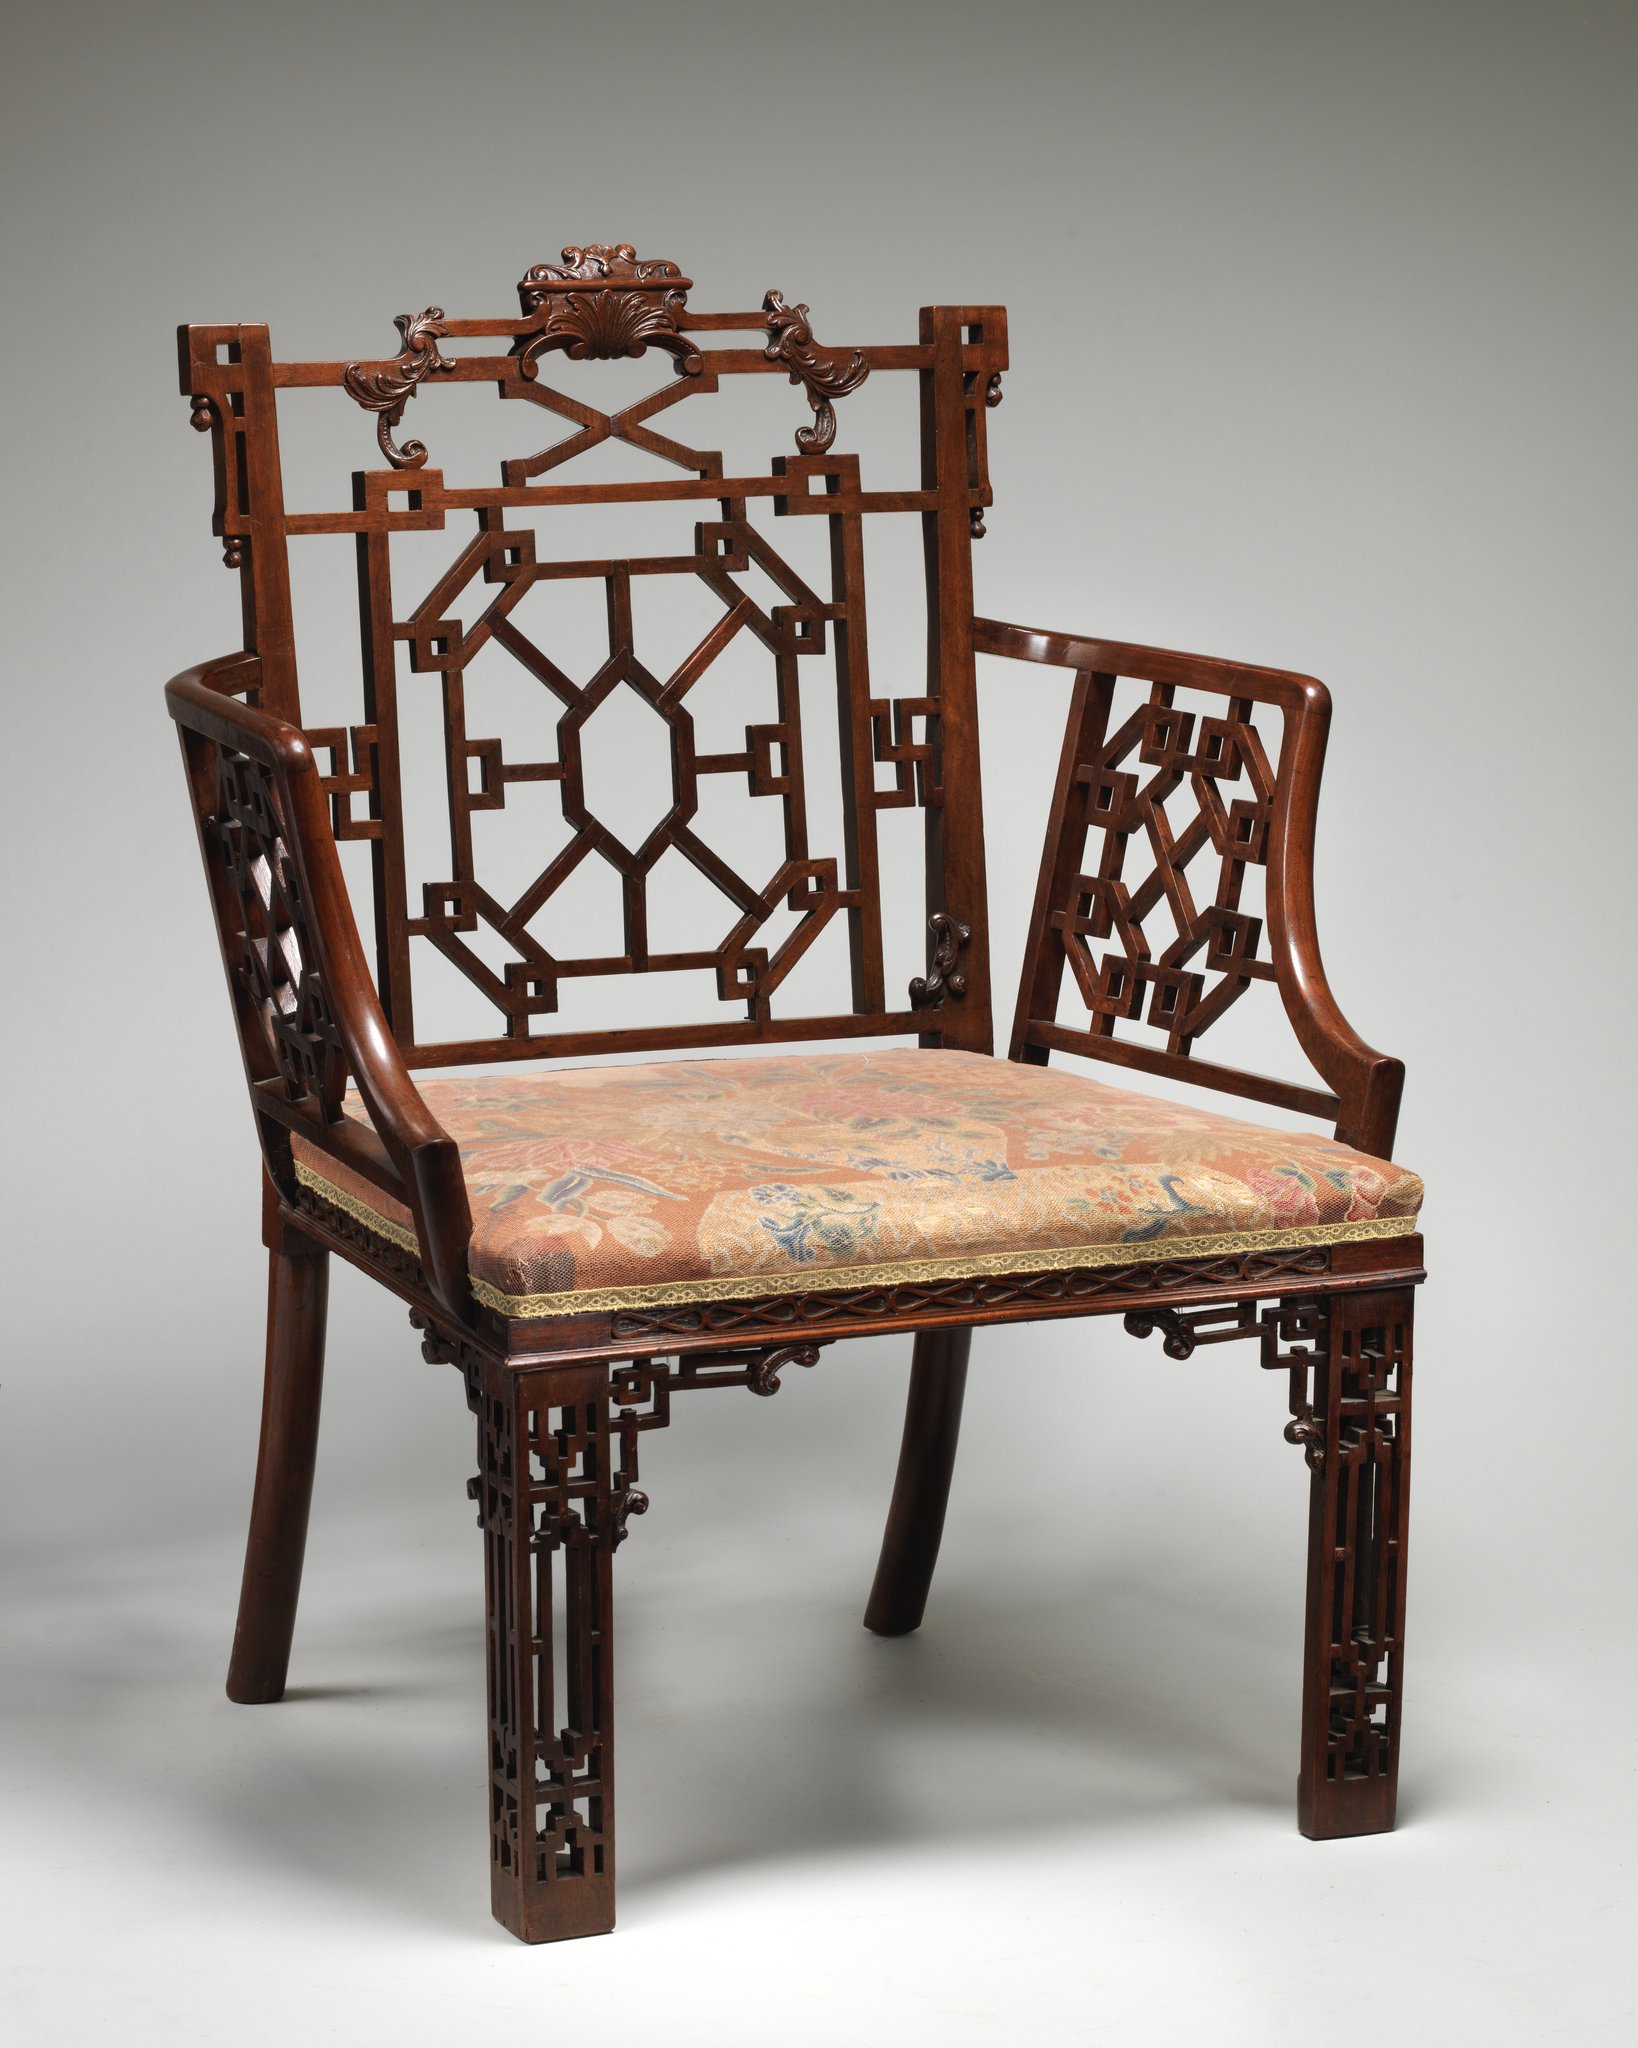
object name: armchair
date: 1755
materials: wood